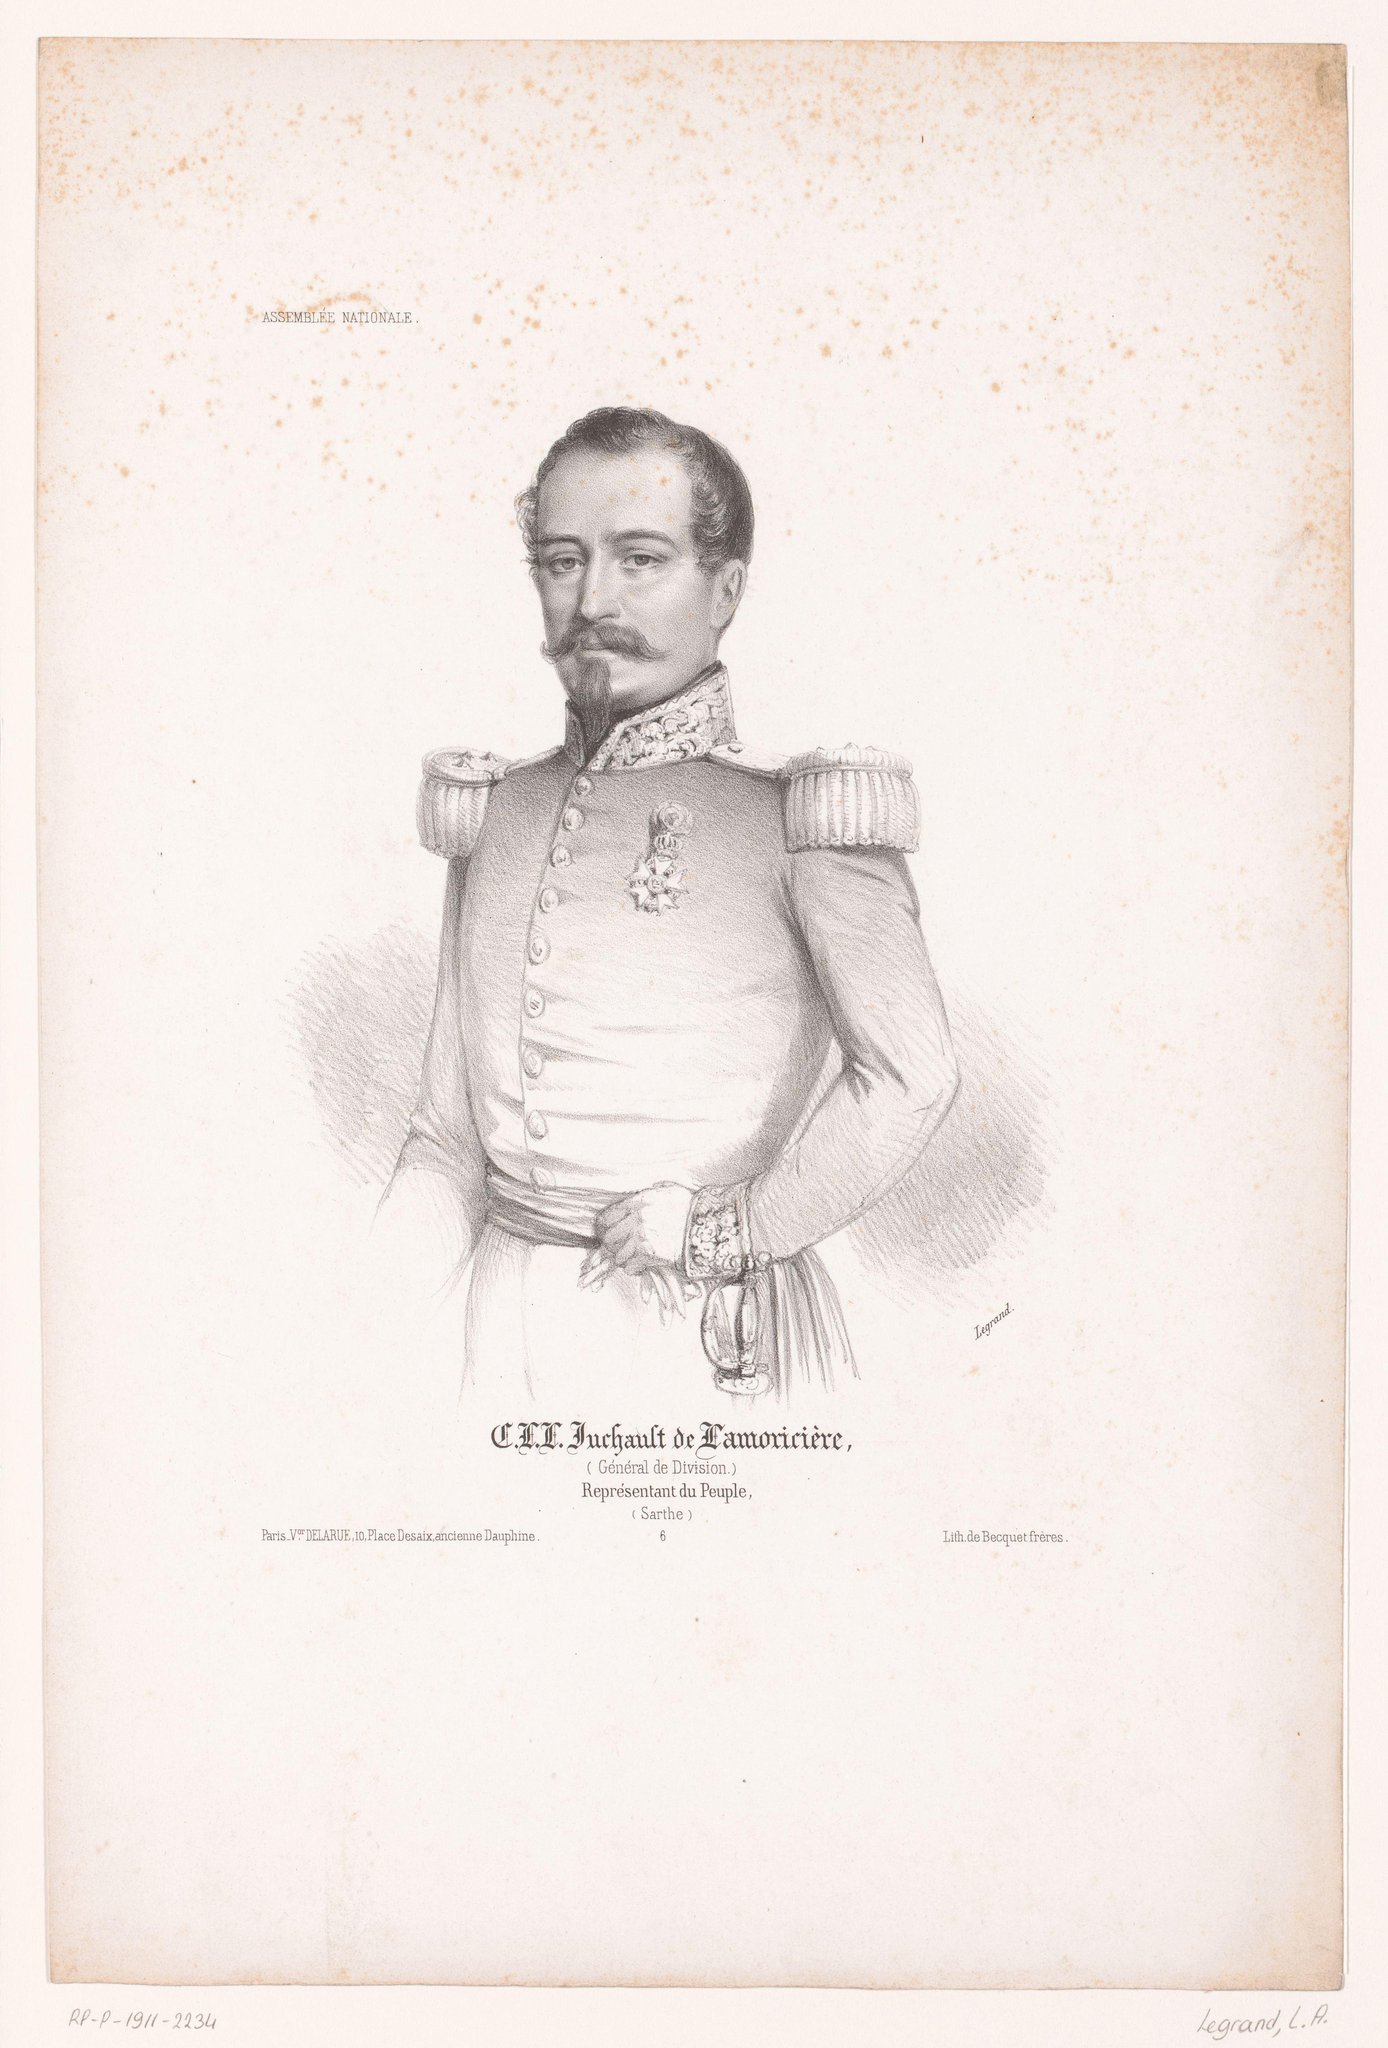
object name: print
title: Portret van Louis Juchault de Lamoricière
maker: auguste legrand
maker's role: draughtsman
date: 1848-1849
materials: paper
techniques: lithograph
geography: paris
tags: historical persons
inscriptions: collector's mark: Lugt 2228a